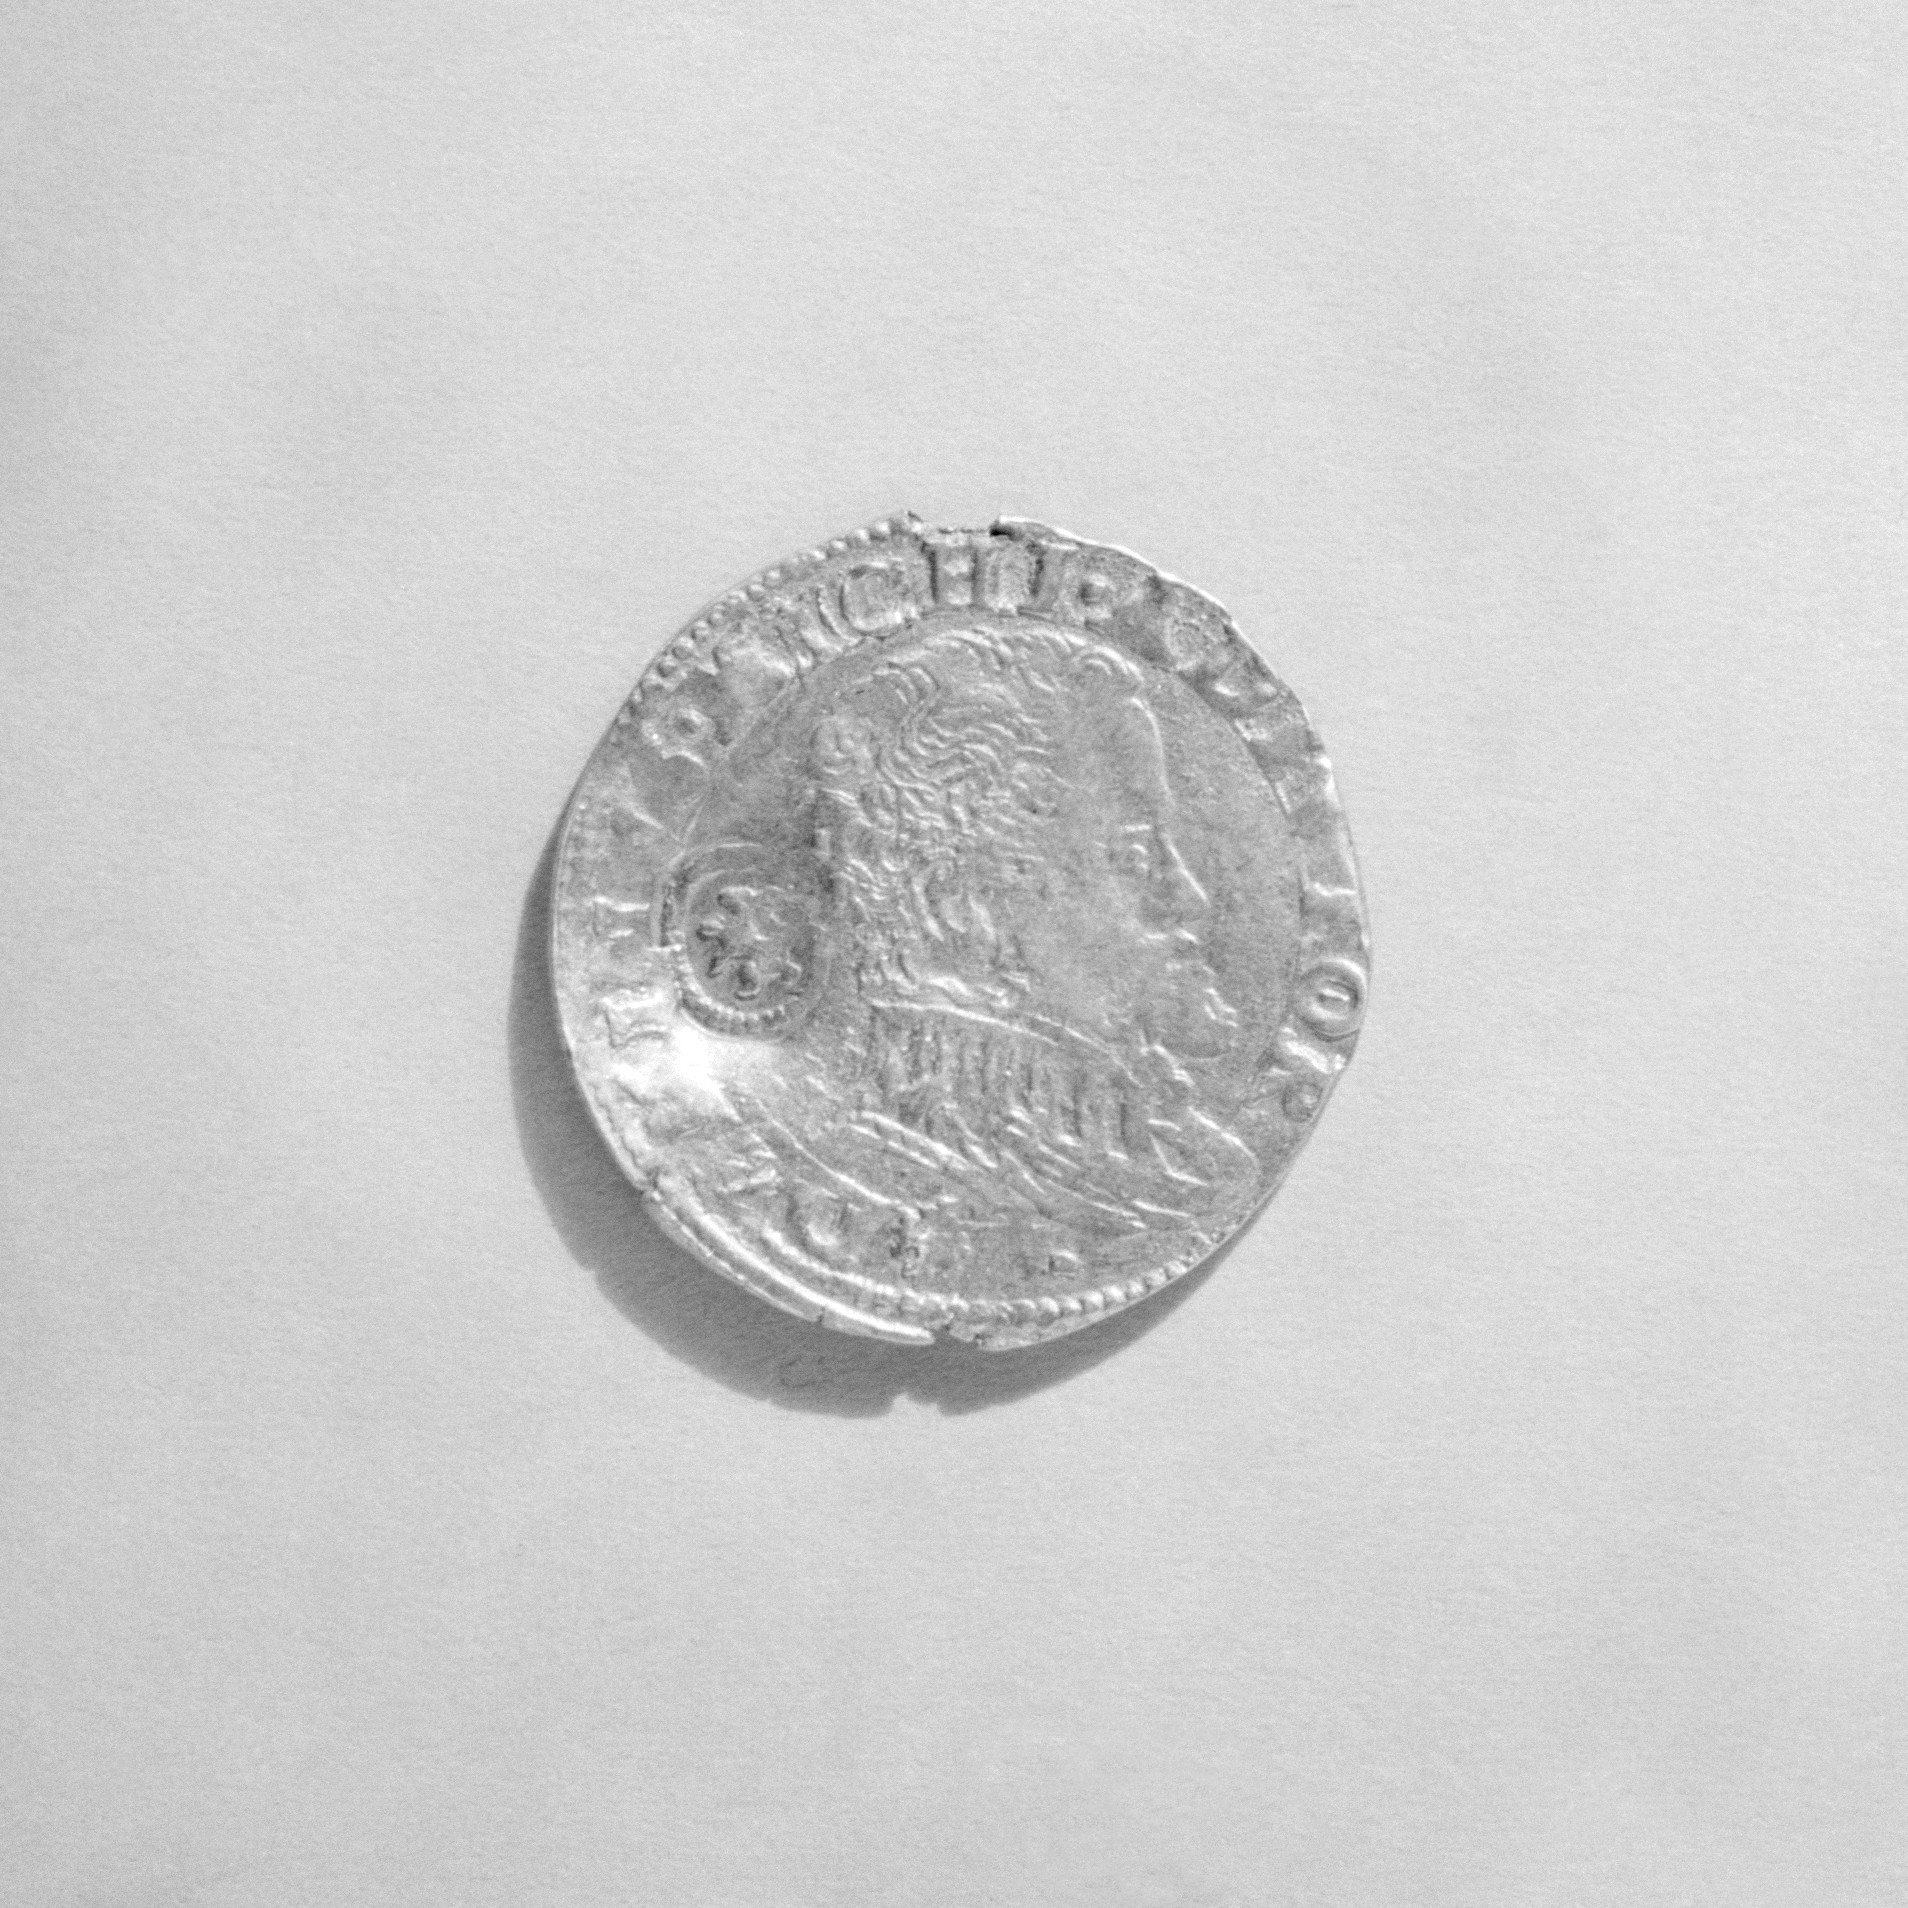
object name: coin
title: Philip II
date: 1555-1576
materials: gold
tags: men,profiles,coins,coat of arms